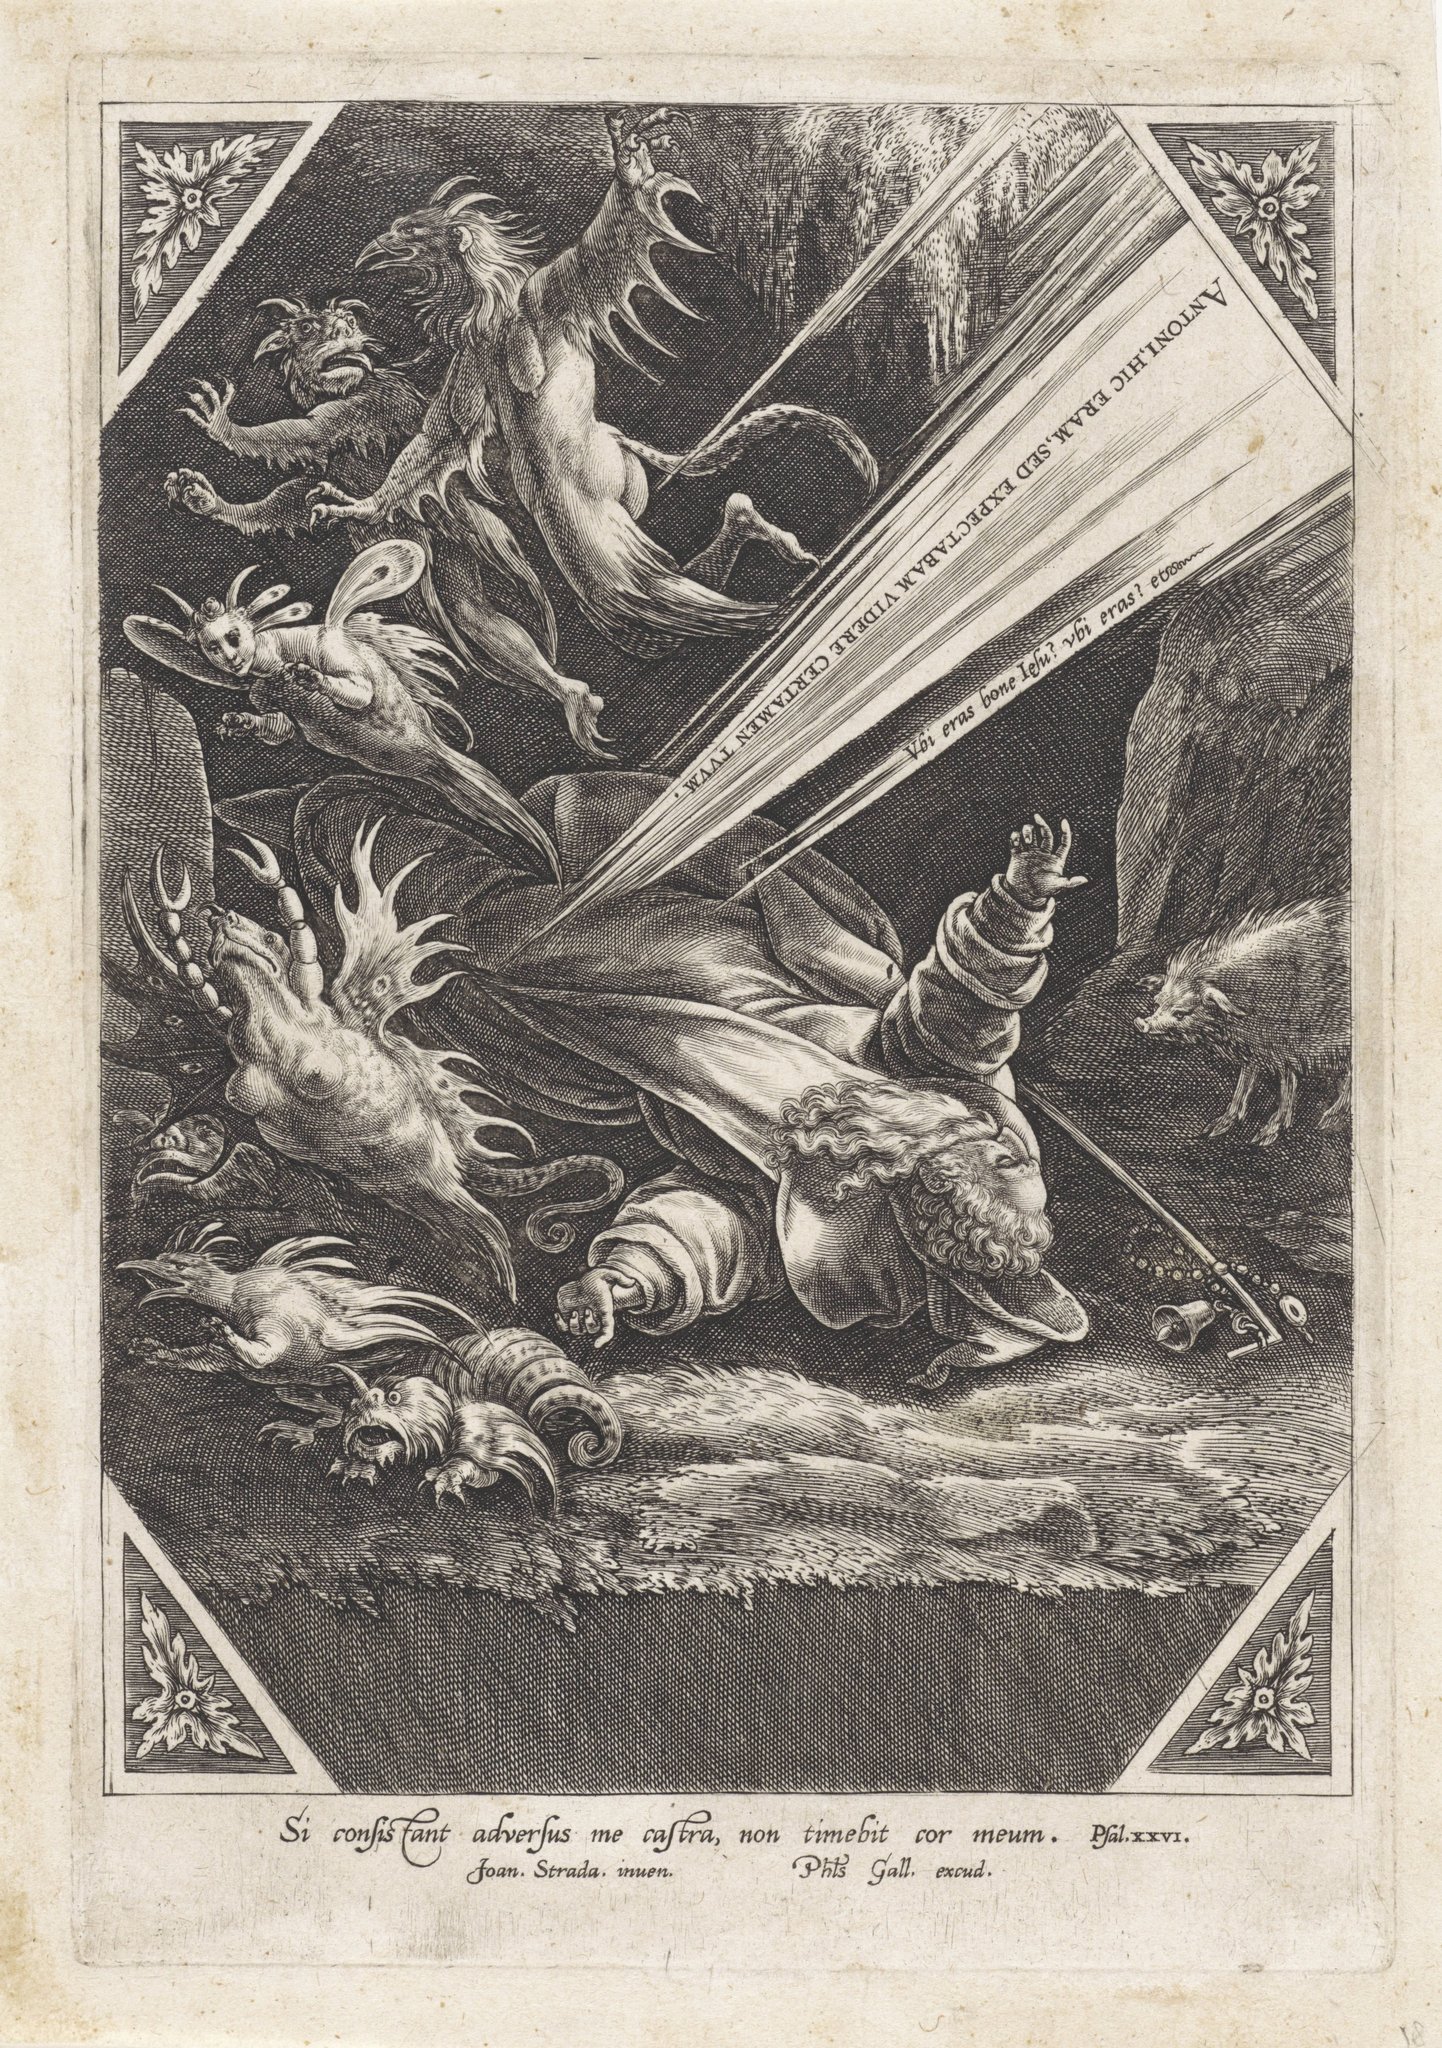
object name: print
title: Verzoeking van de H. Antonius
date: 1500-1599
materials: paper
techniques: engraving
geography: netherlands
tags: st. antony abbot tormented by devils, attacking him on the ground or carrying him aloft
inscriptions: collector's mark: Lugt 2228, collector's mark: Lugt 2760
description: De H. Antonius ligt op zijn rug op de grond voor een grot. Boven zijn hoofd vliegen duivelachtige wezens. Een llichtstraal van Antonius naar de hemel heeft de tekst: Ubi eras bone Jesu? Ubi eras ? Etc....Een tweede lichtstraal uit de lucht naar het lichaam van de heilige heeft de tekst: Antoni, hic eram, sed expectabam videre certamen tuum. Op de grond liggen staf en bel. Rechts het zwijn.